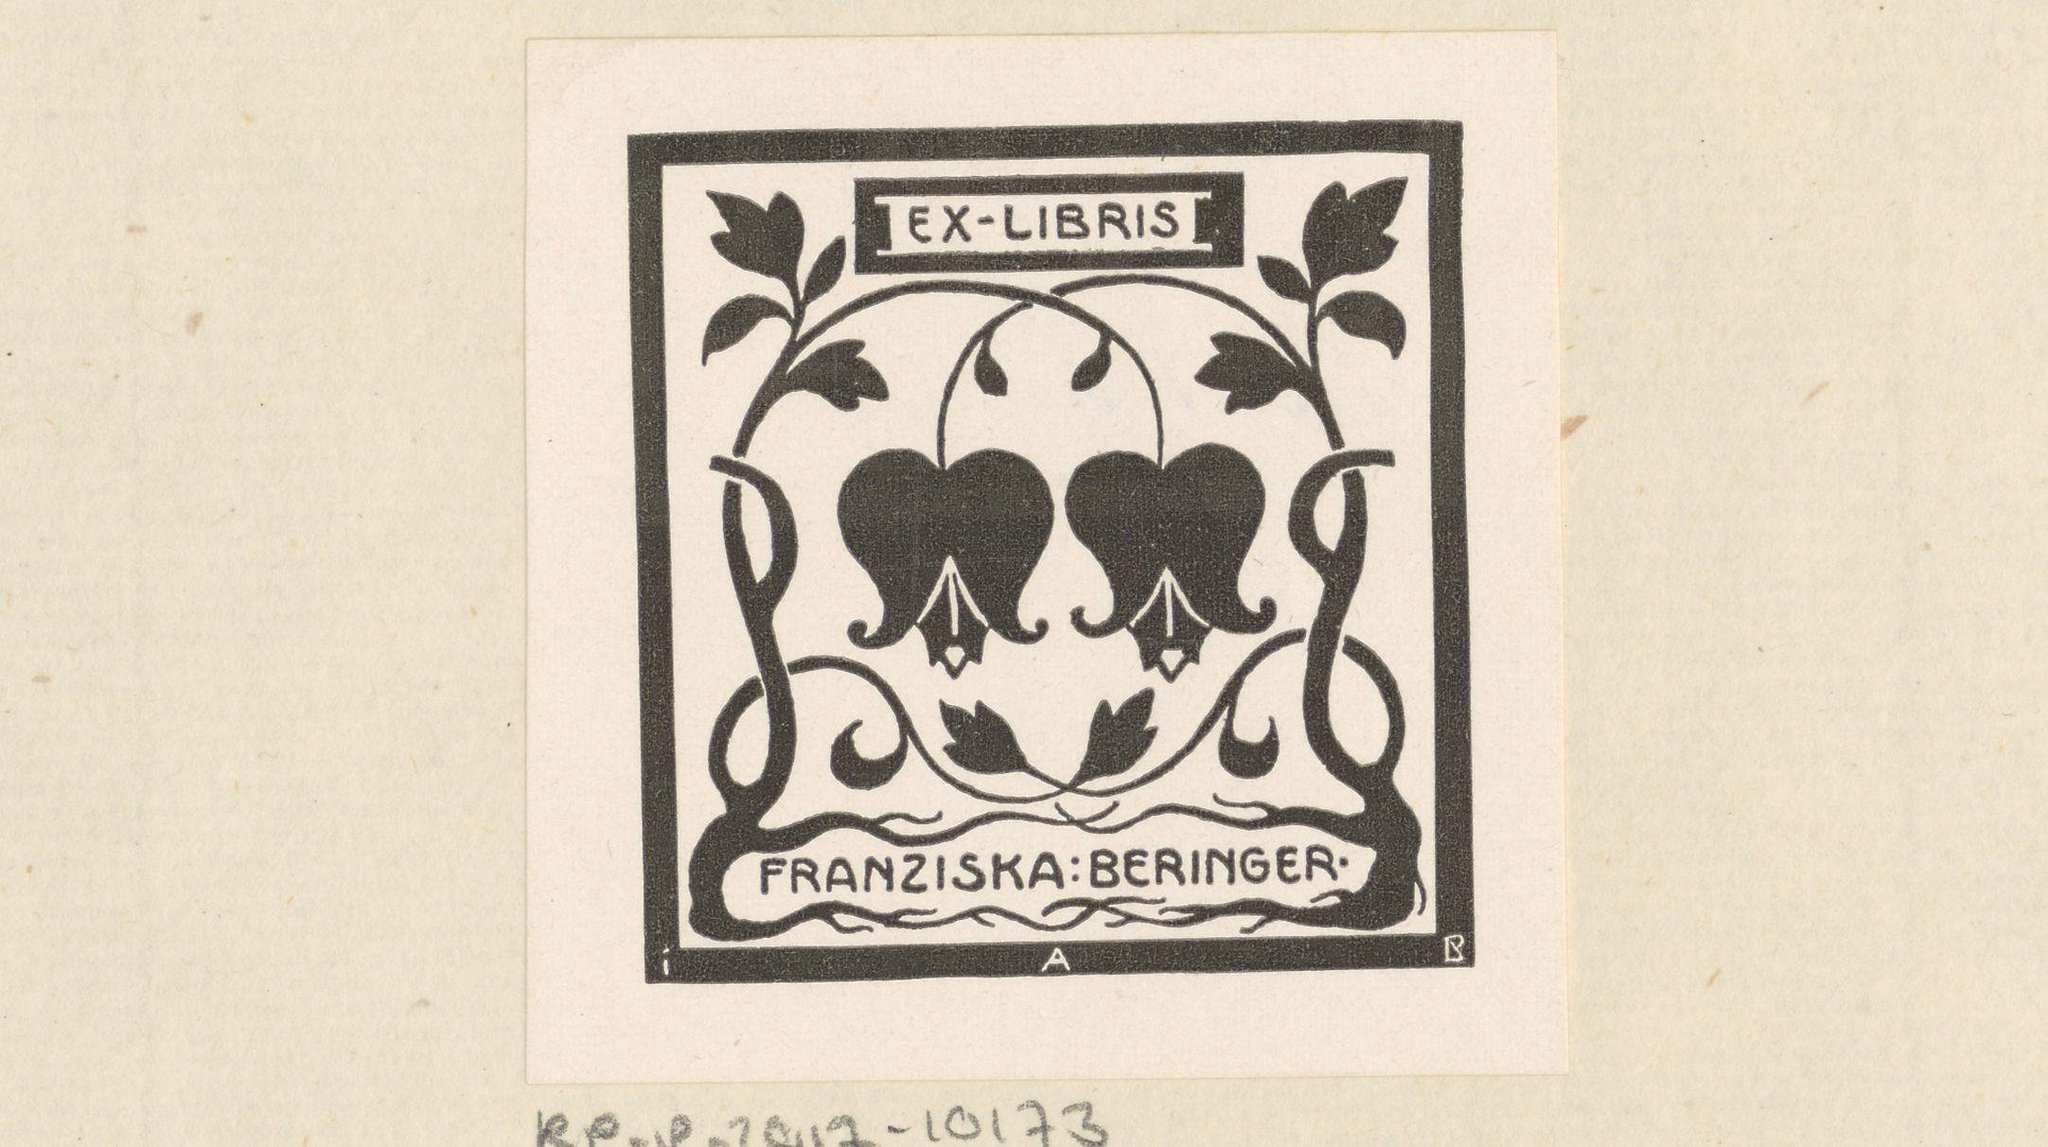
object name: bookplate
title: Ex libris van Franziska Beringer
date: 1904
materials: paper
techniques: printing block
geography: germany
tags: flowers